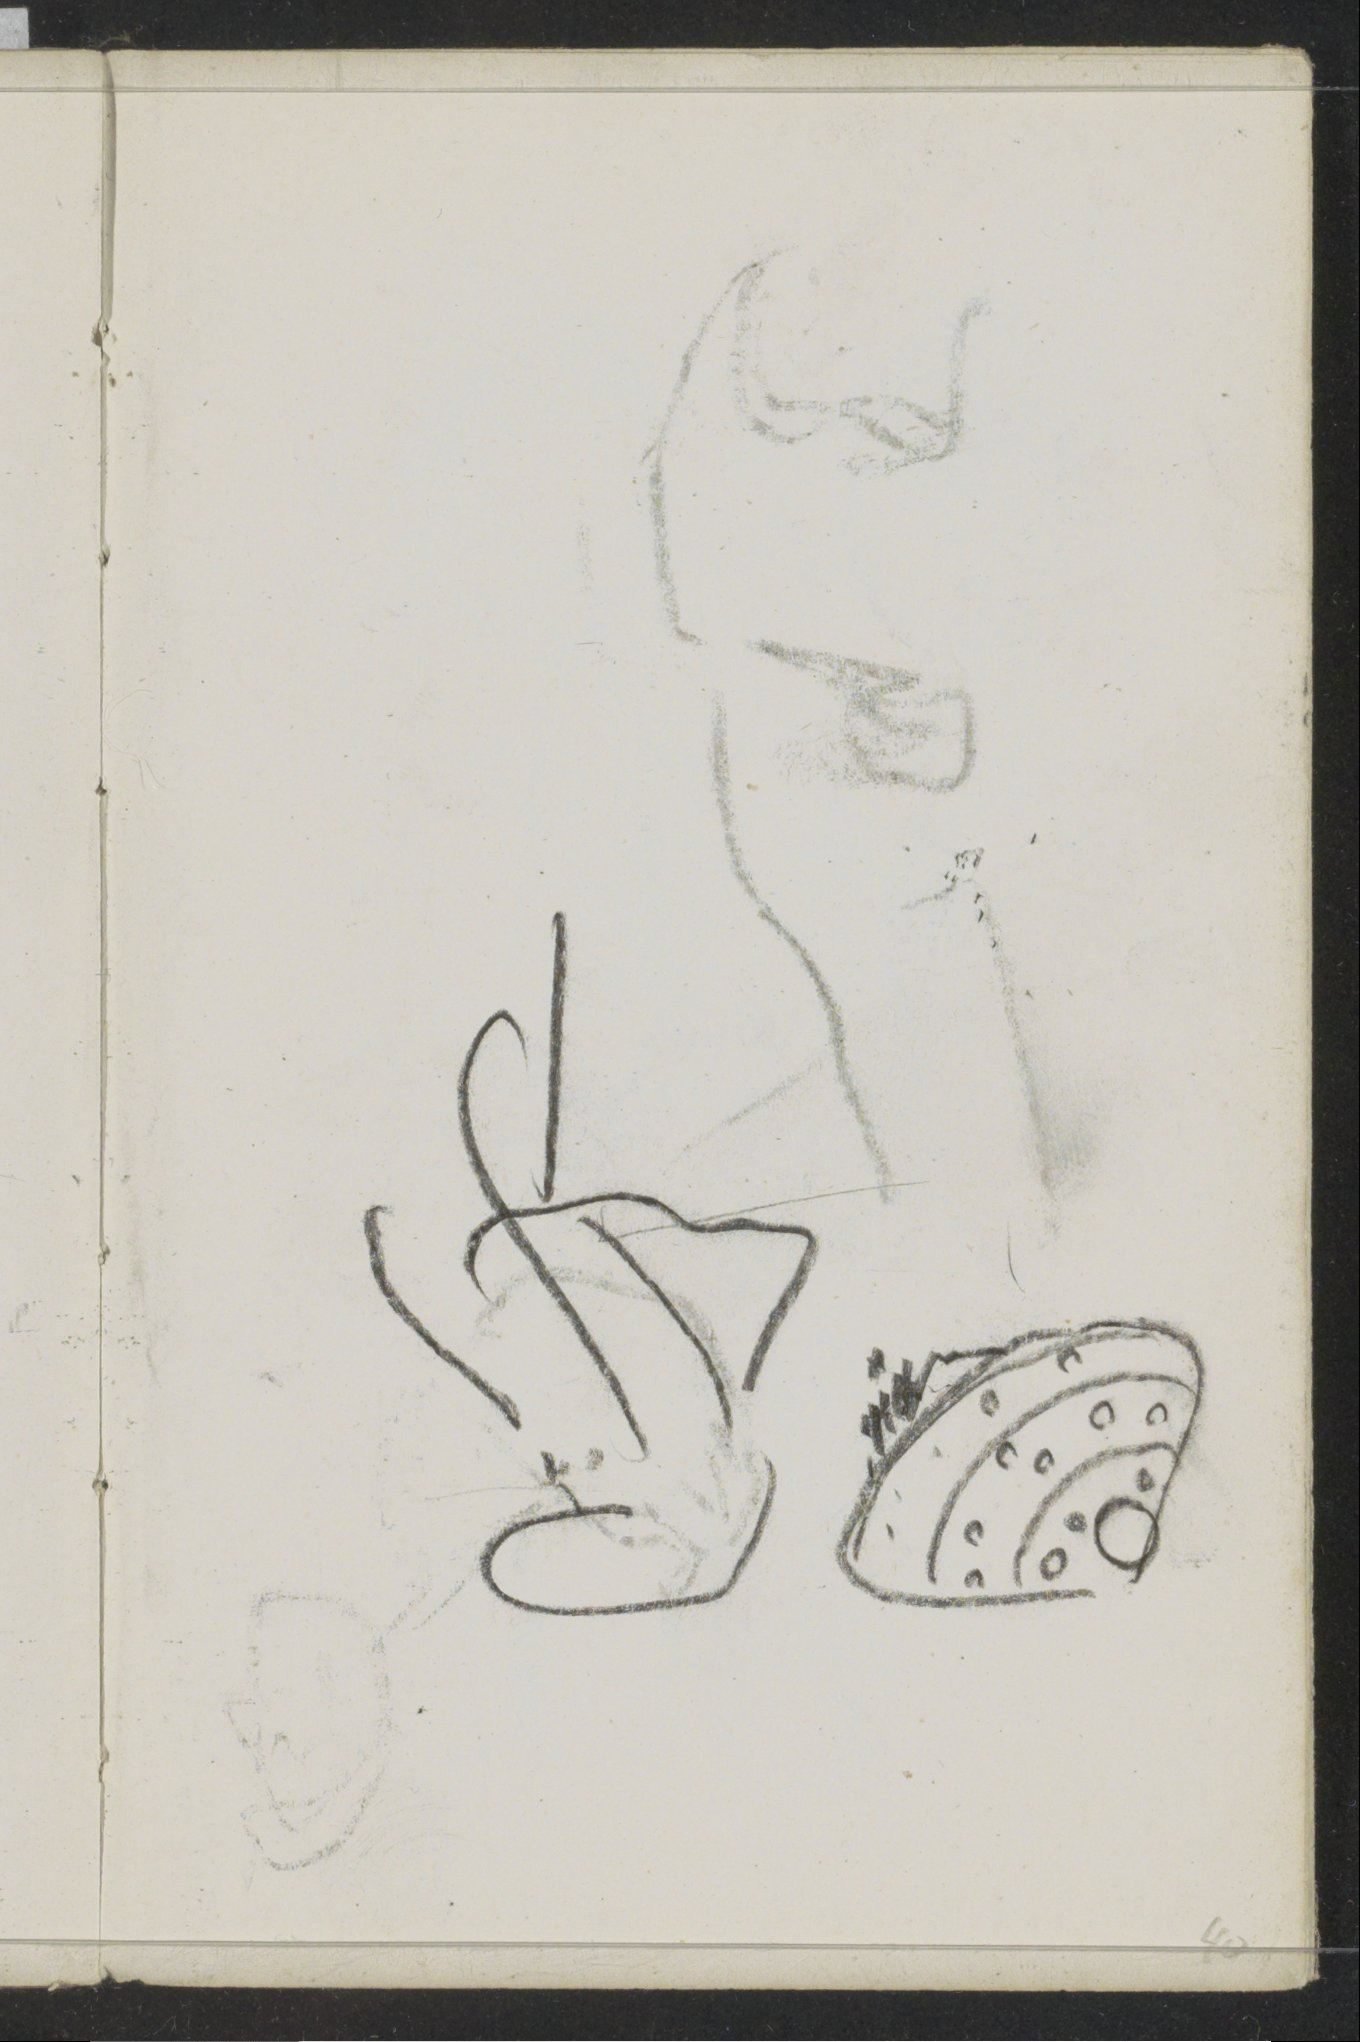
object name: sketchbook leaf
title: Studies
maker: carel adolph lion cachet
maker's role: draughtsman, print maker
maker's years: 1864-1945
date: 1874-1945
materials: chalk, paper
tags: head-gear: hat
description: Mogelijk is één van de studies van een hoed. Blad 40 recto uit een schetsboek met 41 bladen.